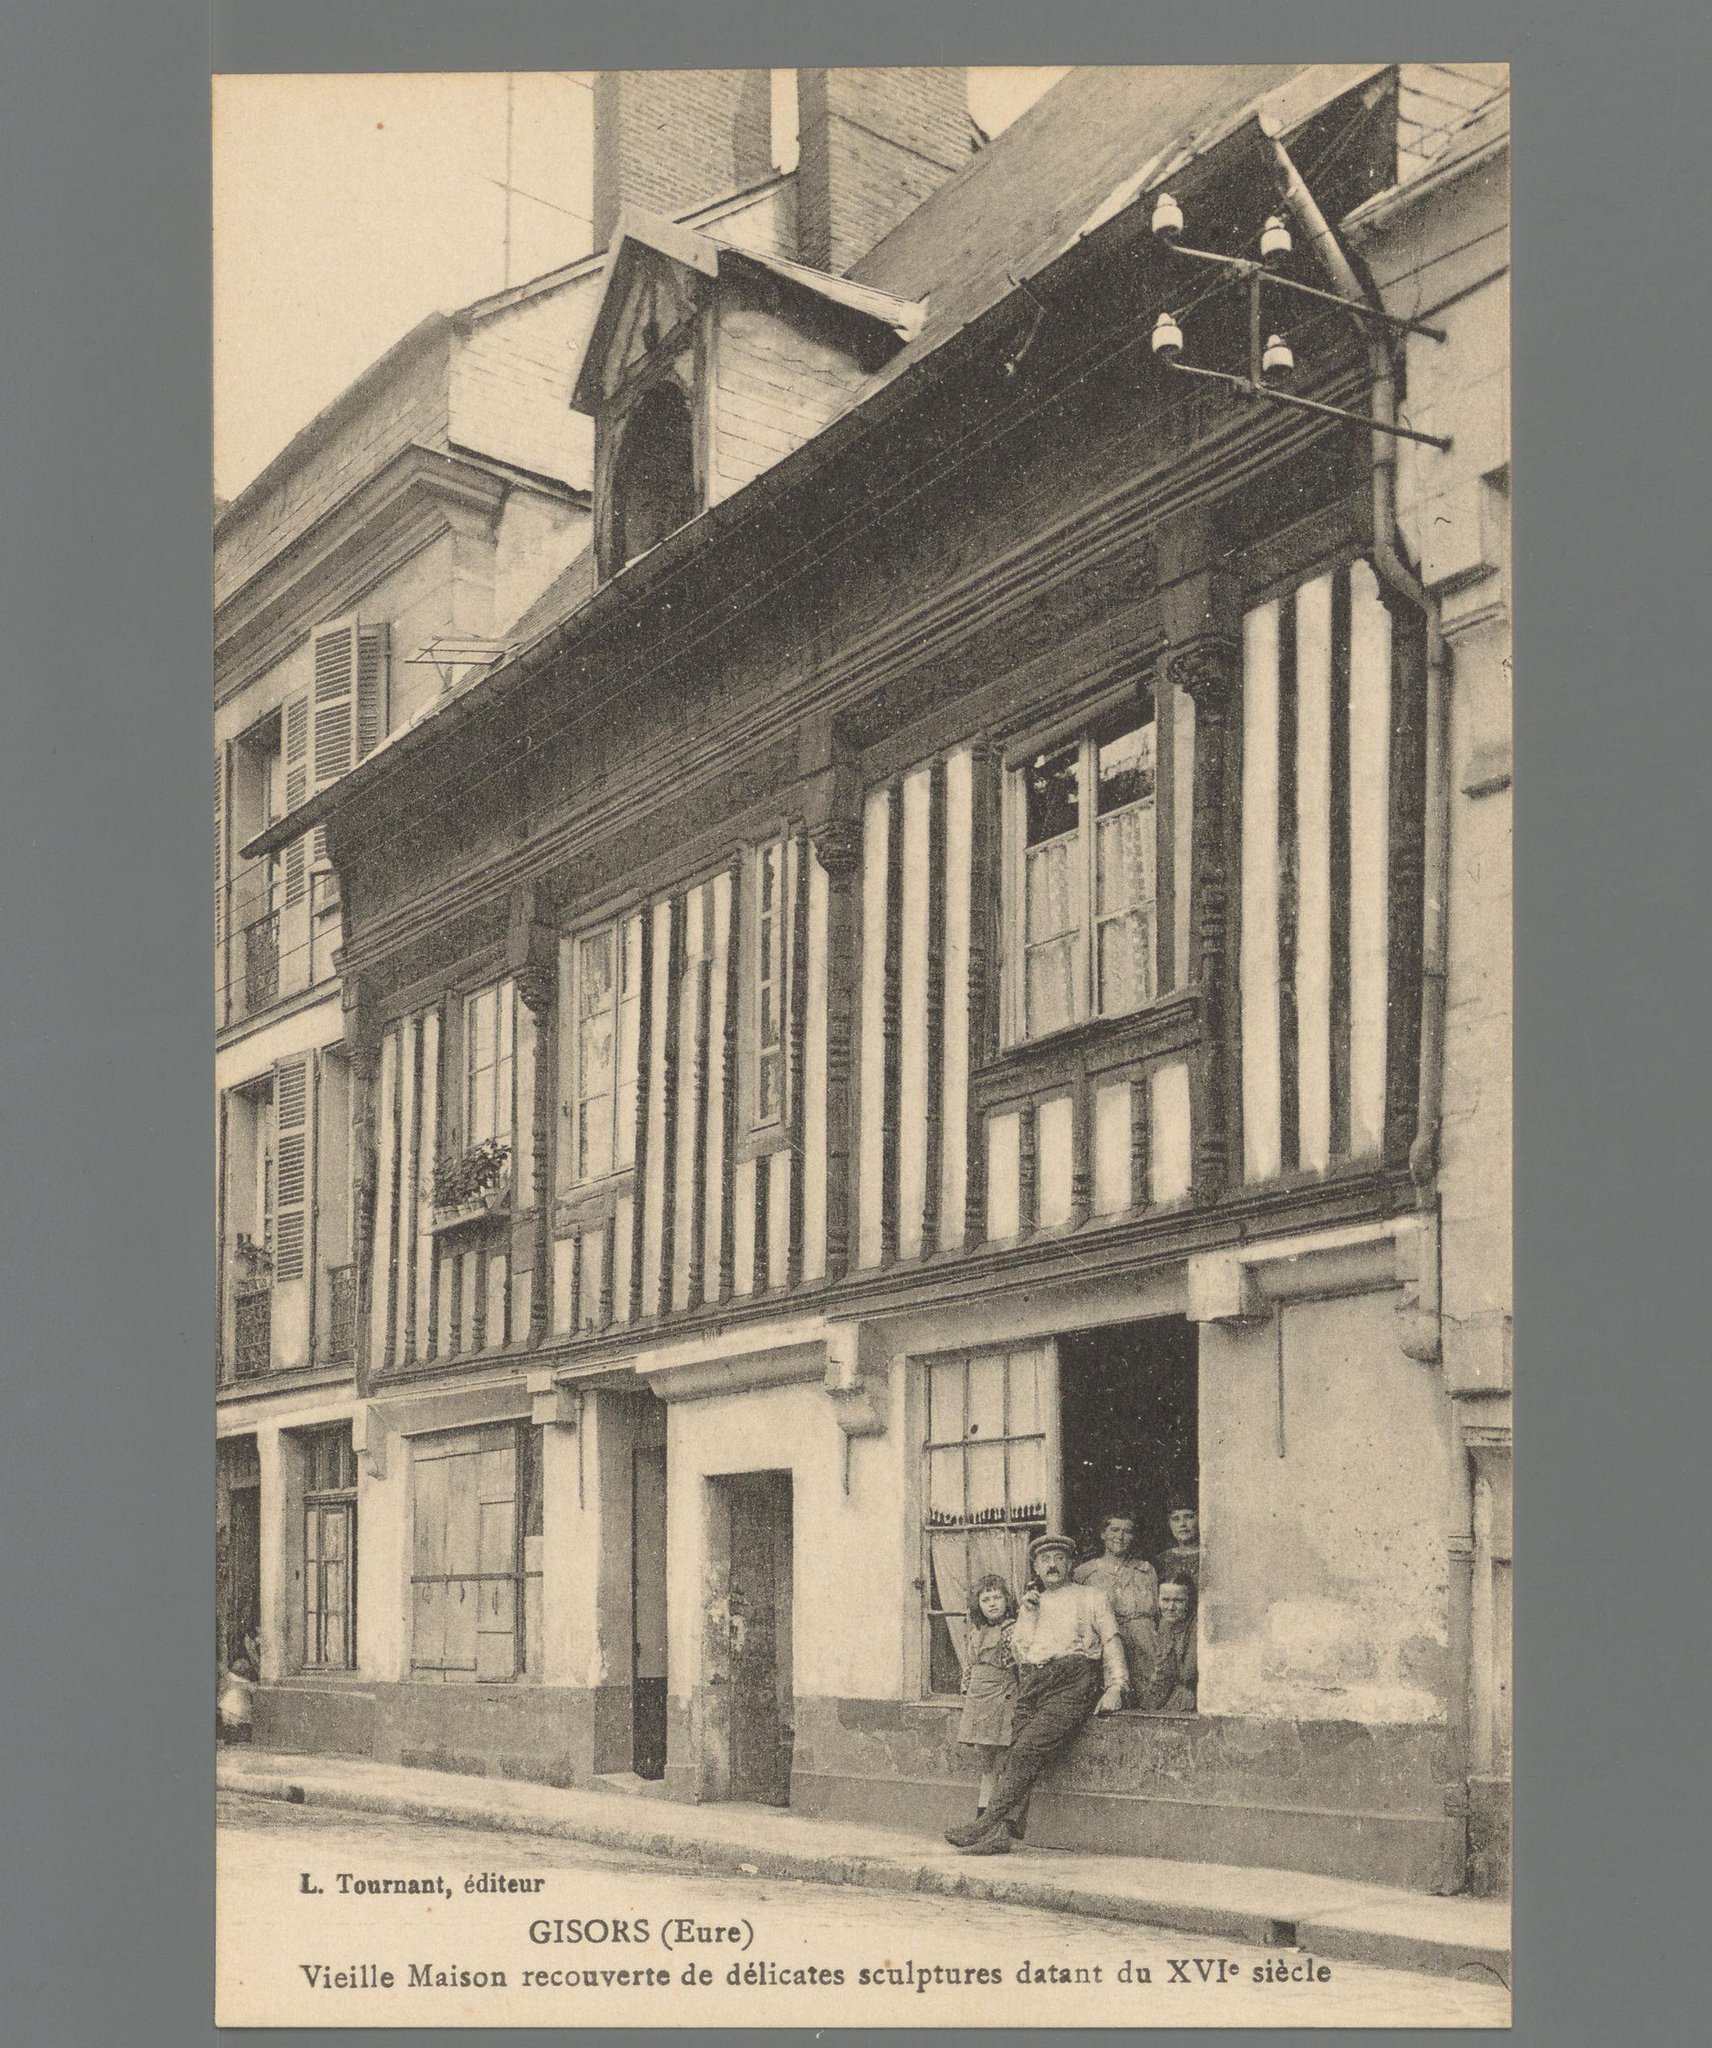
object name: ansichtkaart, prentbriefkaart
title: Gisors (Eure). Vieille Maison recouverte de délicates sculptures datant du XVIe siècle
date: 1903-1930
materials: cardboard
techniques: photograph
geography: gisors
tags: façade (of house or building)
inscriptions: collector's mark: ‘AFE v S’